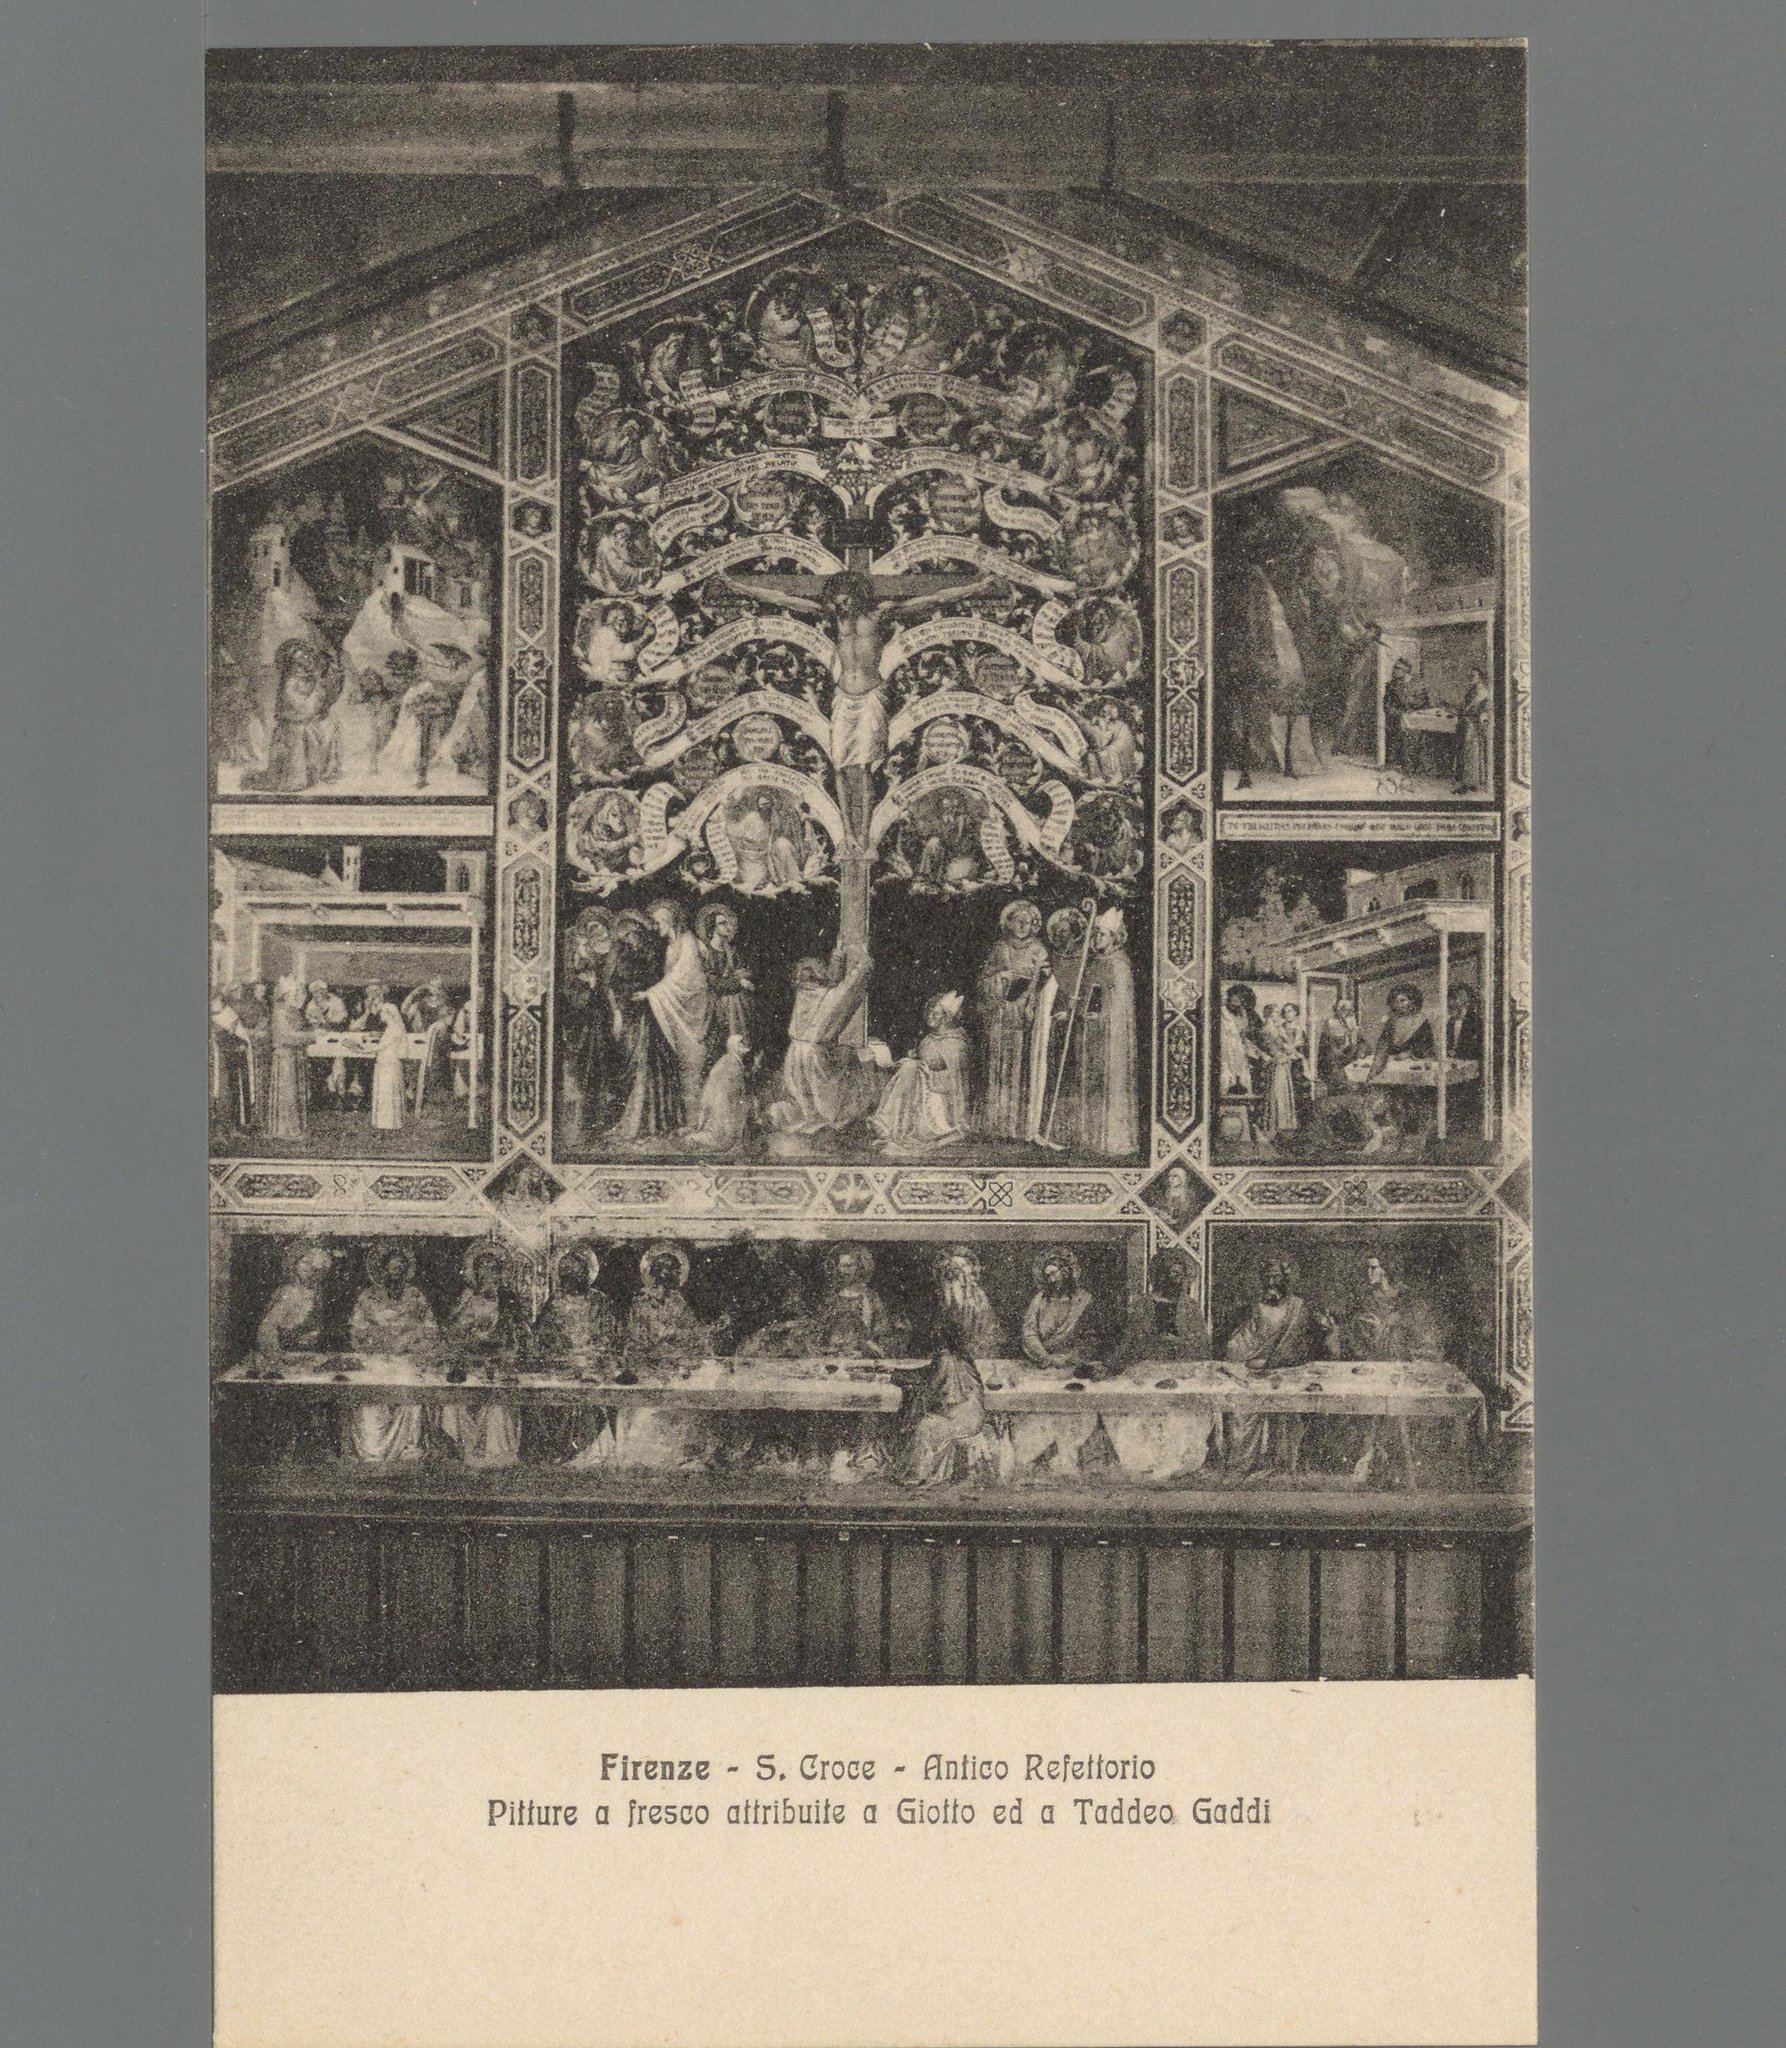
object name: photomechanical print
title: Firenze - S. Croce - Antico Refettorio. Pitture a fresco attribuite a Giotto ed a Taddeo Gaddi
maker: Anonymous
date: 1910-1930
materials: cardboard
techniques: photograph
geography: florence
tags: church (exterior), statues, paintings, etc. ~ objects of worship in roman religion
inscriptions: collector's mark: ‘AFE v S’